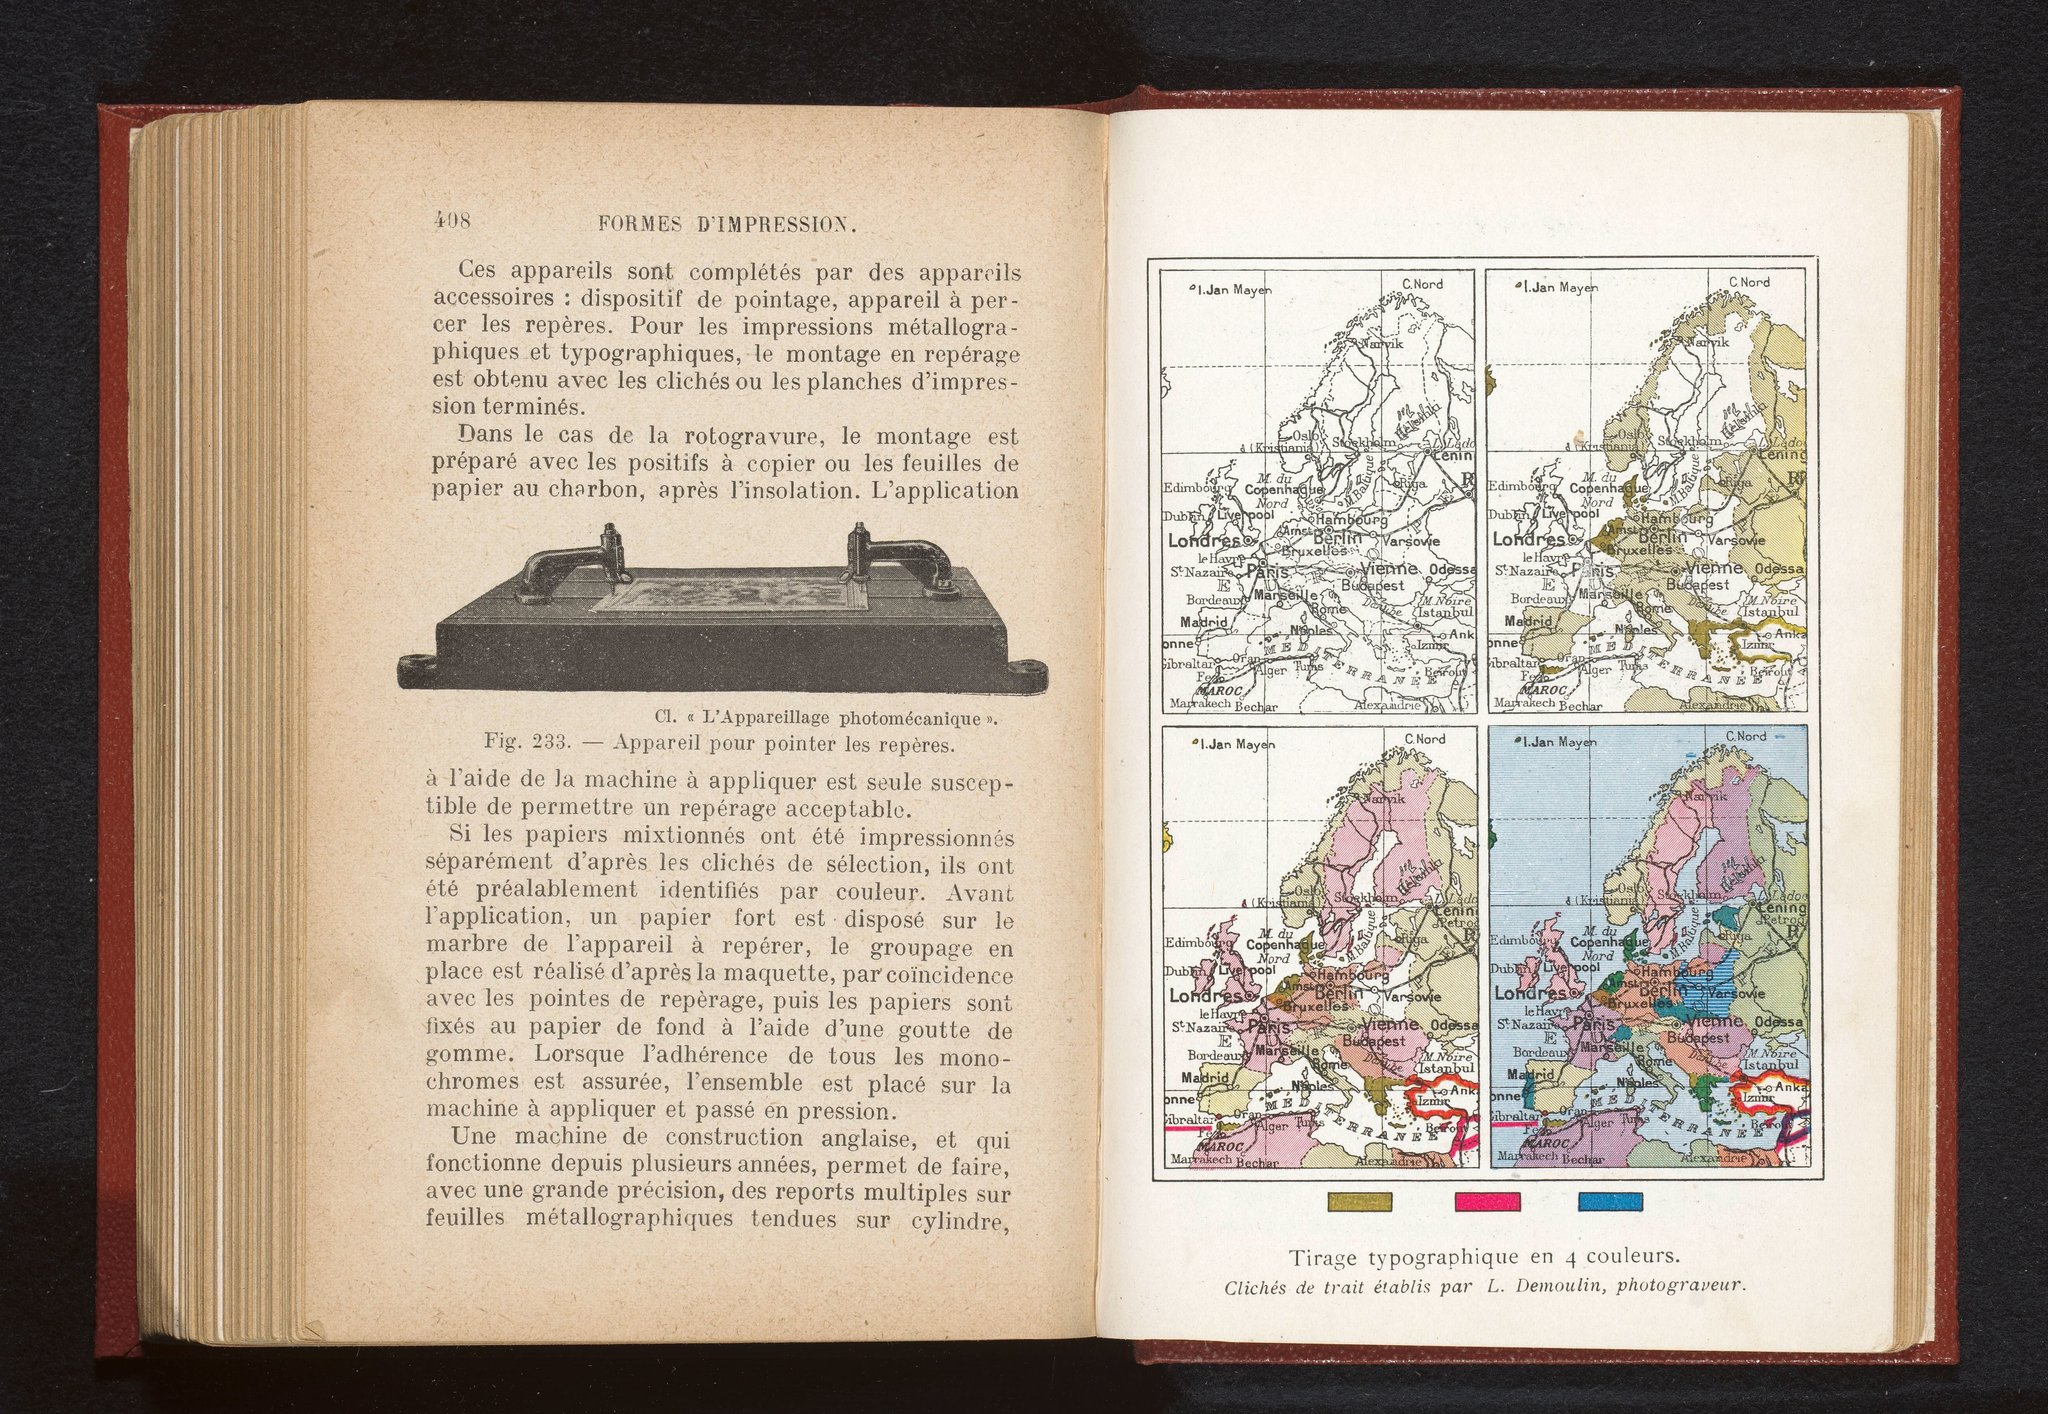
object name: page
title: Appareil pour pointer les repères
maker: Anonymous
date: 1922-1932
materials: paper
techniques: autotype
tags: photographic apparatus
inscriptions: name: ‘Cl. l'Appareillage photomécanique.’